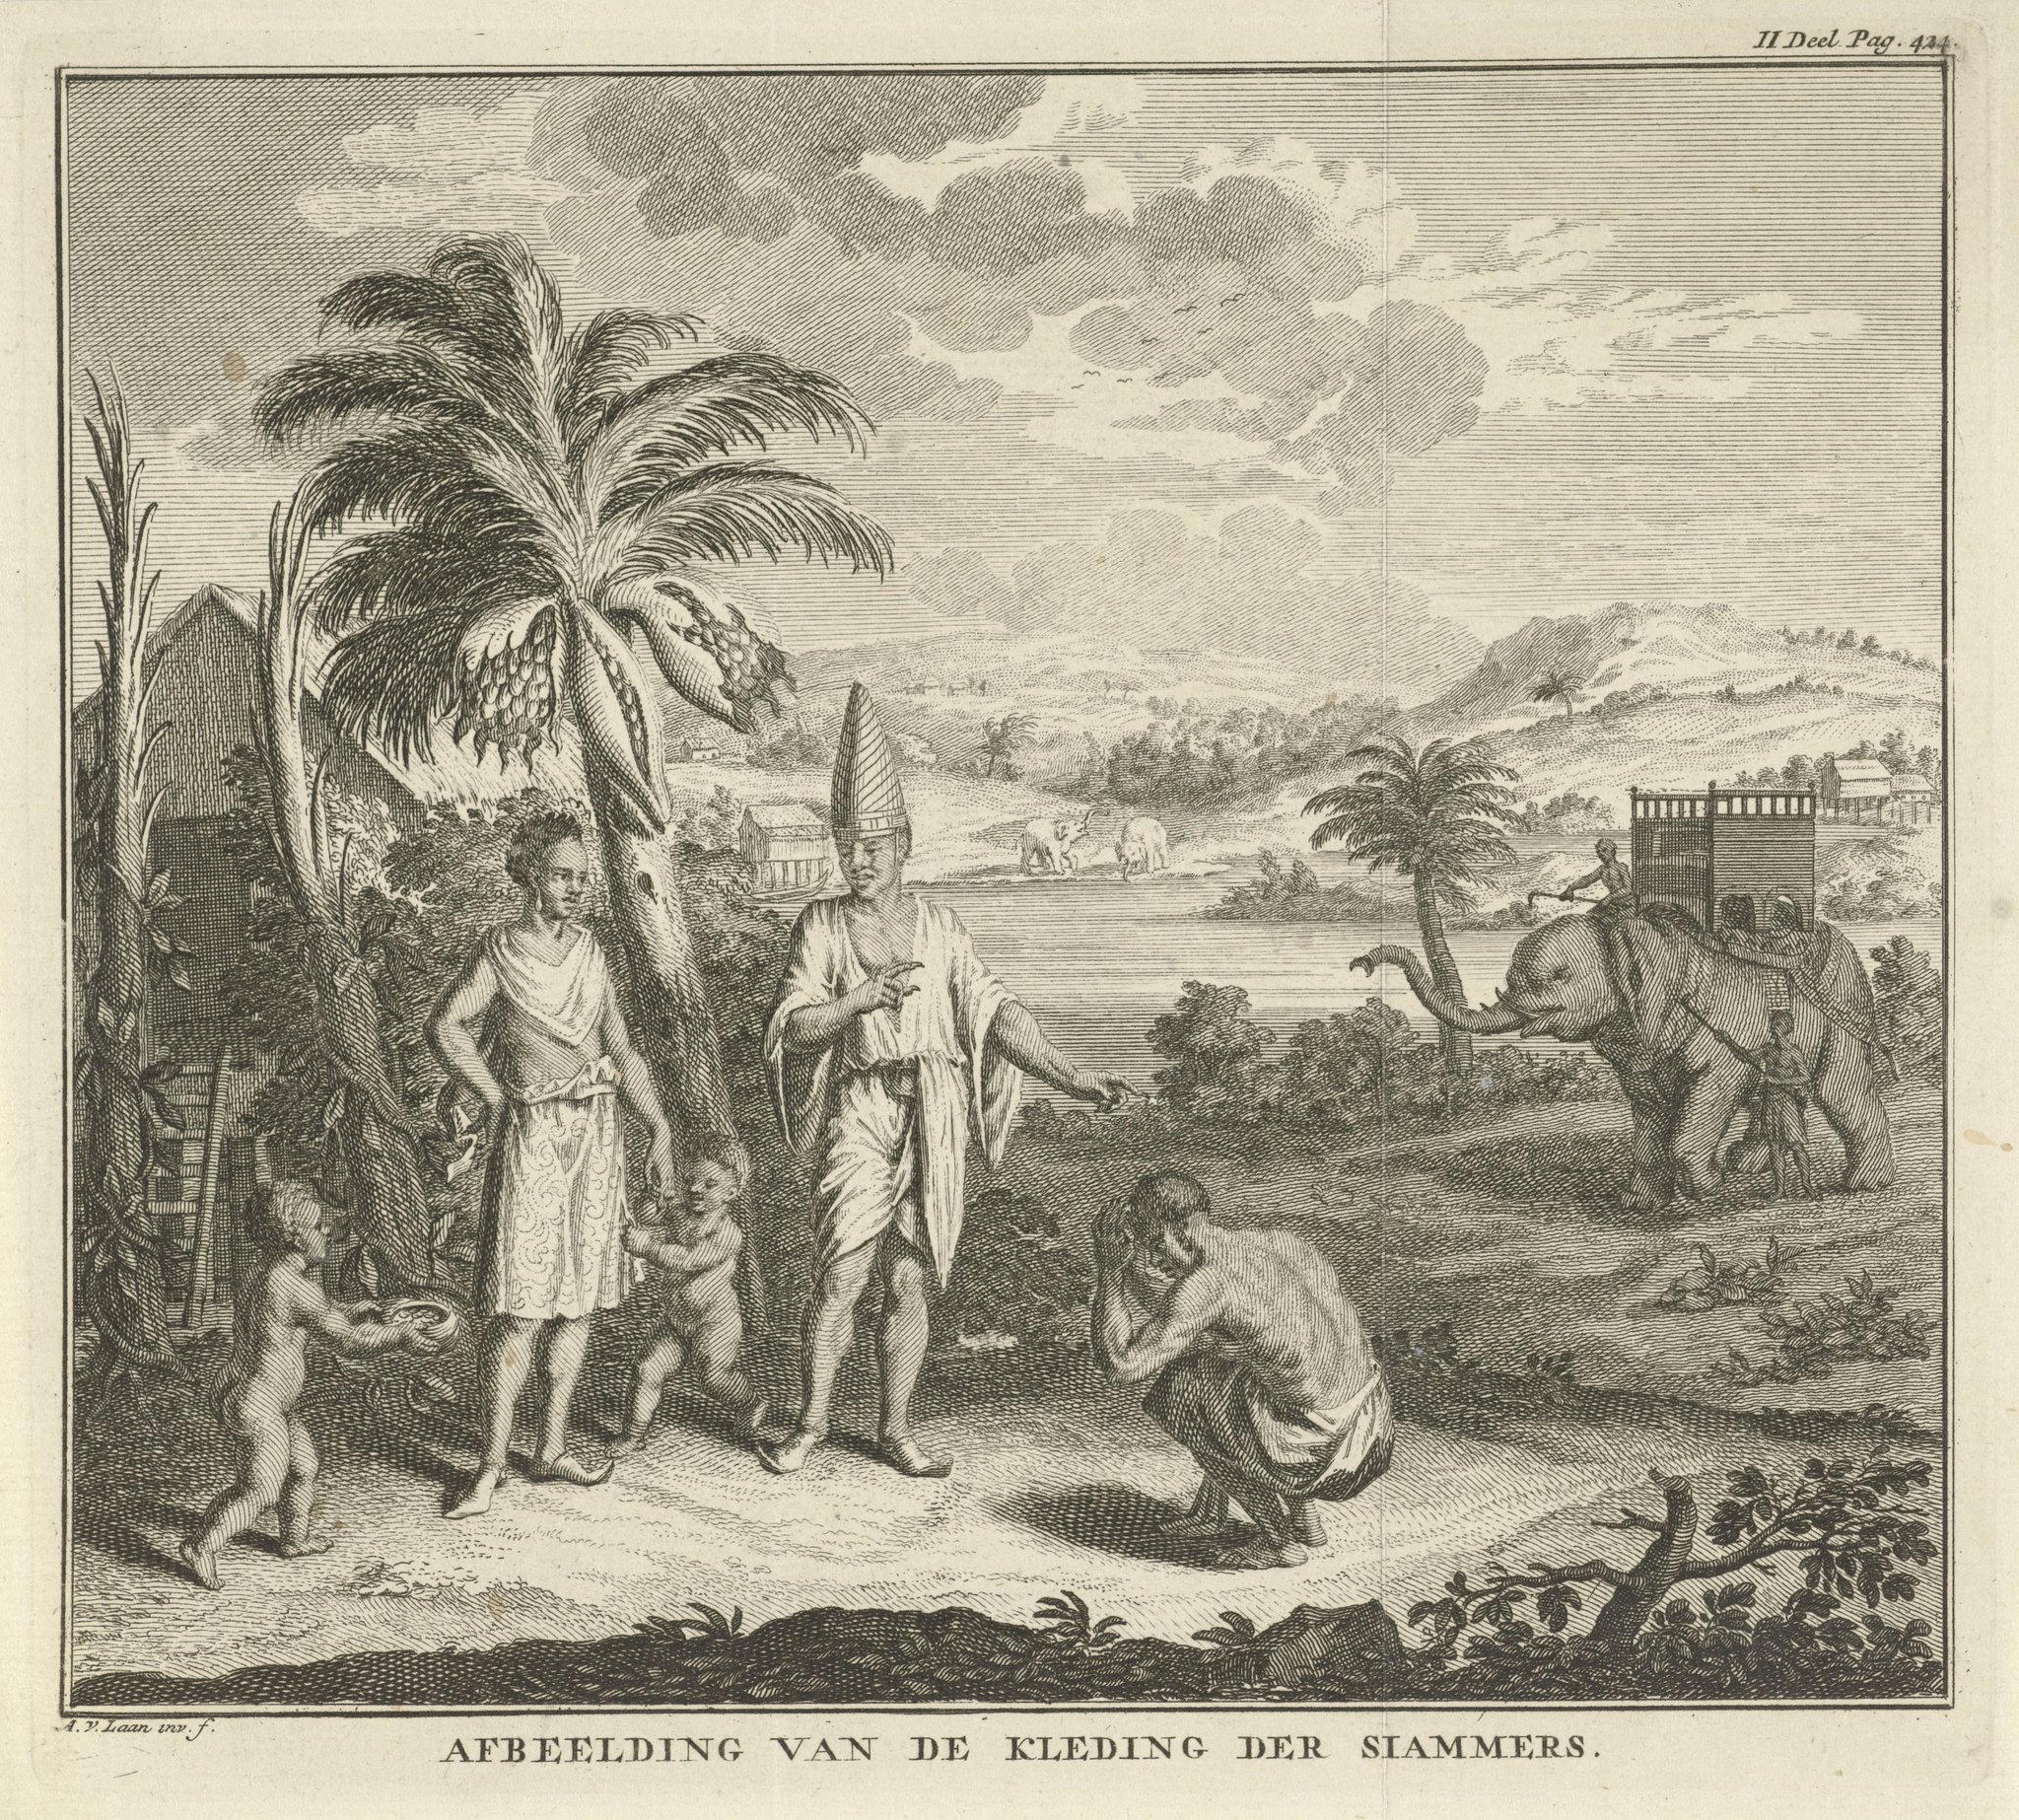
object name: book illustration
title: Siamese Landscape with People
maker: adolf van der laan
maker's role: draughtsman, print maker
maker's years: 1689-1742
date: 1730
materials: paper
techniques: etching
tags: asiatic races and peoples (with name), landscapes in tropical and sub-tropical regions, kneeling figure, trunked animals: elephant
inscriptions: collector's mark: Lugt 2228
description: Clearly different motifs from earlier prints have here been combined to create a new scene. The elephant and the nobleman with the crouching enslaved man come from one travel account, while the woman and children are taken from another journal. The depiction of a nobleman and his family with an enslaved man affords a glimpse of the hierarchical structure of Siamese society